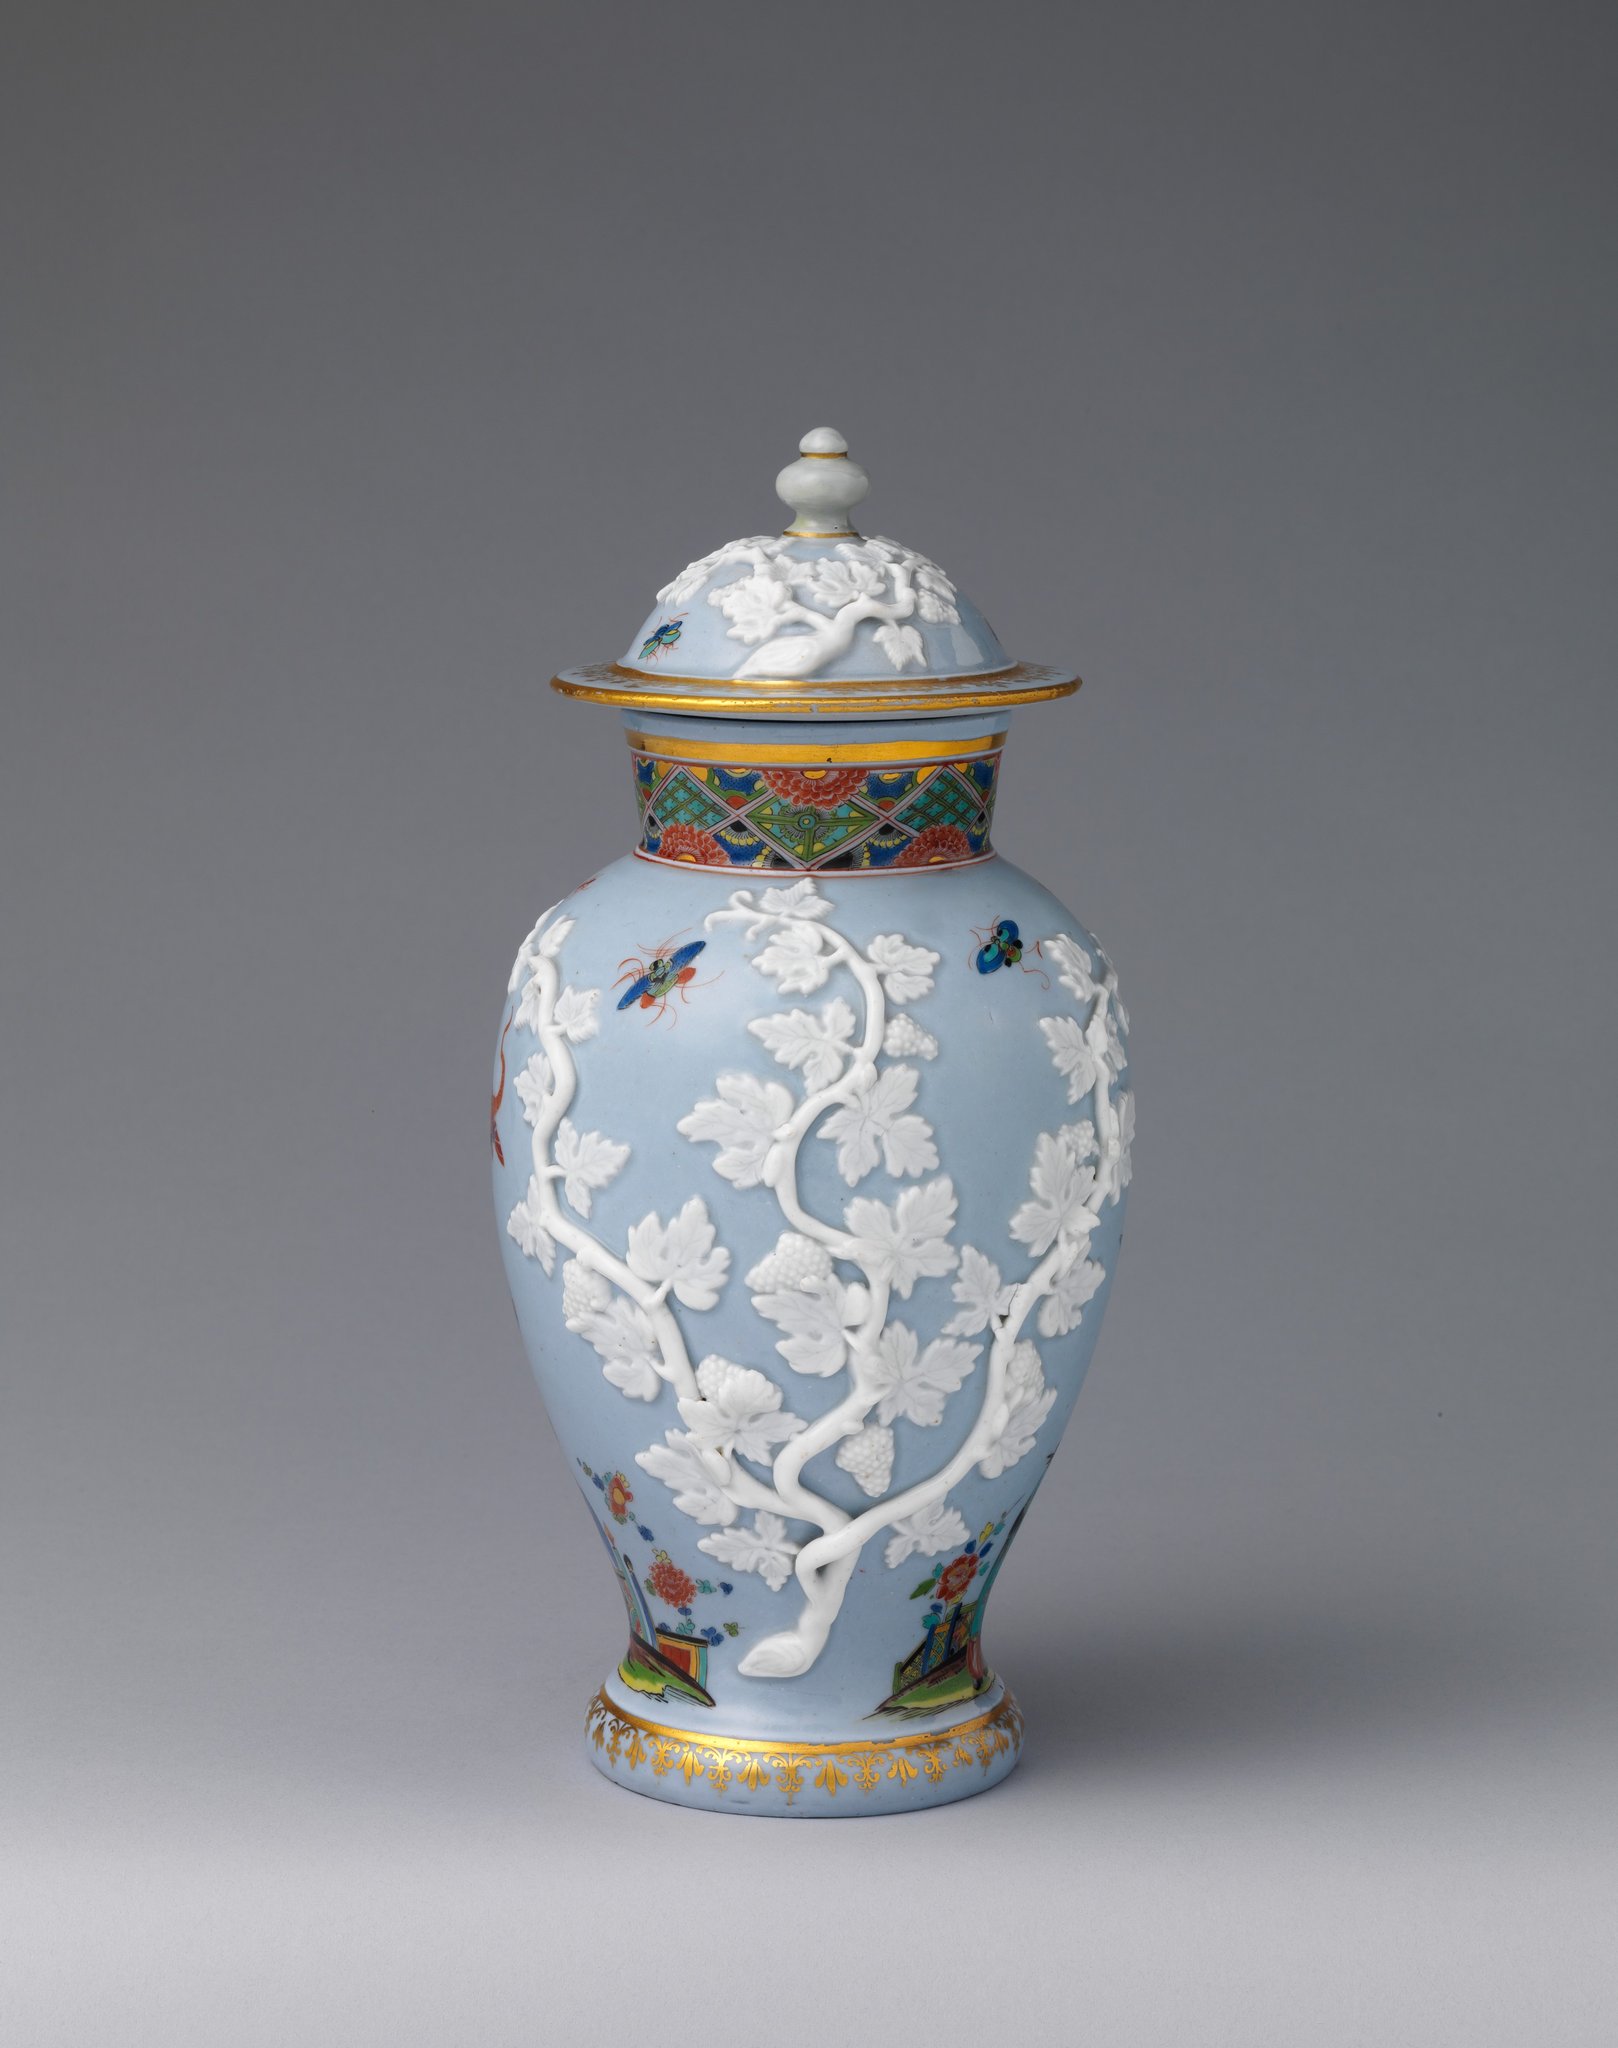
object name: vase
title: Vase (from a garniture of three)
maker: meissen manufactory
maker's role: manufactory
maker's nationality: german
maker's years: 1710-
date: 1725-1730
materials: enamel, gold, hard paste porcelain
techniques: polychrome, tinting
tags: human figures,dragons,butterflies